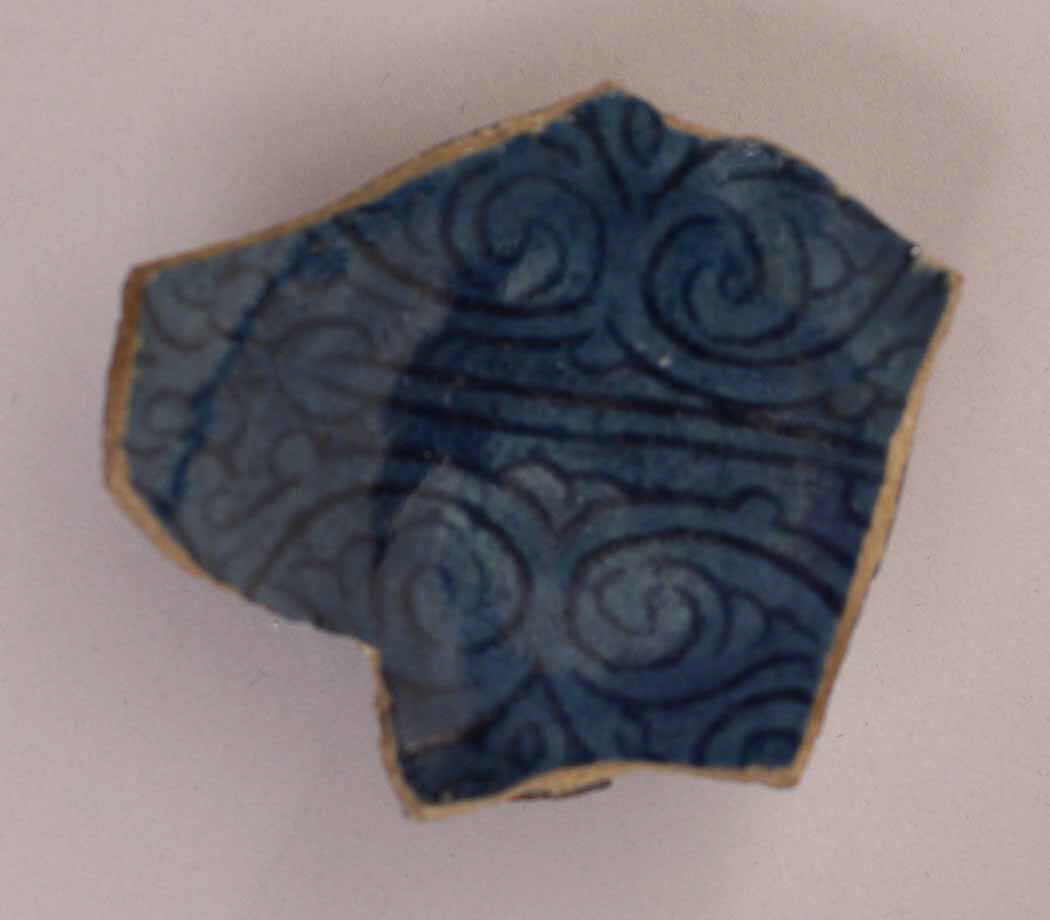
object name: ceramic fragment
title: Fragment of a Bowl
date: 1201-1400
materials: cobalt, earthenware, glaze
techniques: incising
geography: egypt